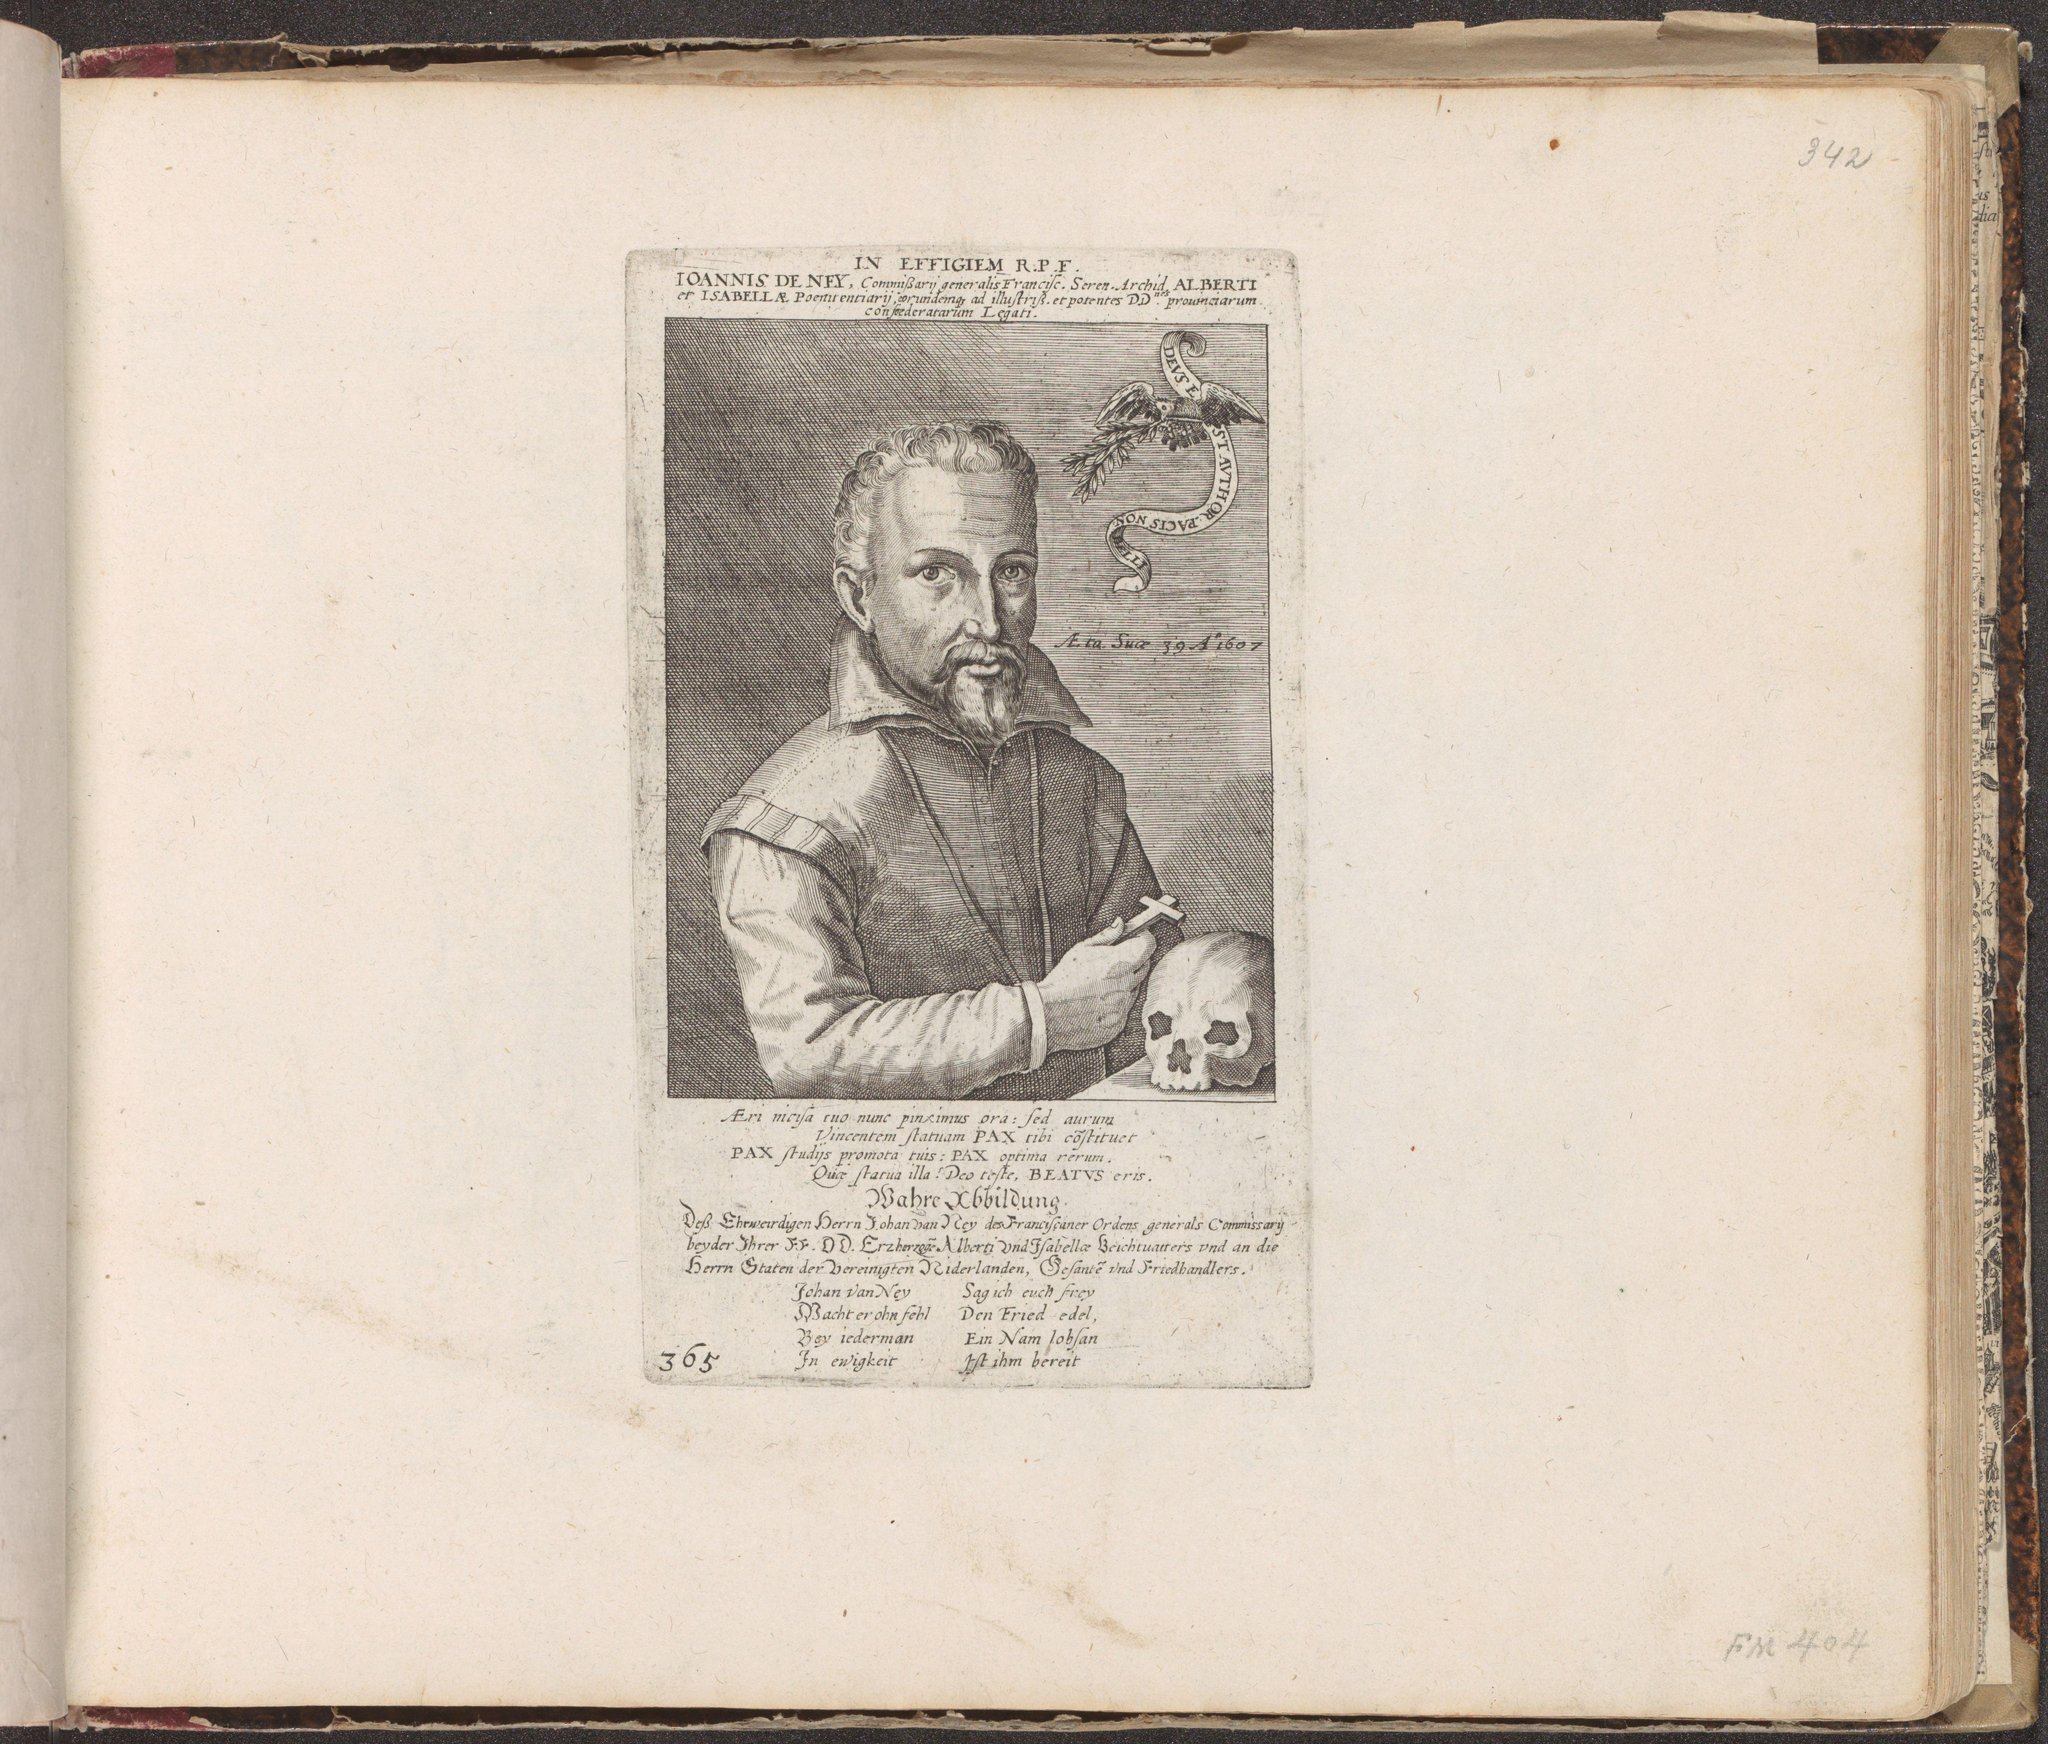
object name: album leaf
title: Serie 11: Varia Buitenlandse Gebeurtenissen, 1571-1631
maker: frans hogenberg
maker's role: print maker, publisher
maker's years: 1538-1590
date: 1607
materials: paper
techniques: engraving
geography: cologne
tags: antwerp, spain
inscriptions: date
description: Portret van Jan de Ney, in 1607 op 39-jarige leeftijd. Staande ten halven lijve met kruis en schedel. Afgezant van Albrecht en Isabella bij de vredesonderhandelingen voor het Twaalfjarig Bestand. Met onderschrift van 4 regels in het Latijn en 4 regels en een vers van 8 regels in het Duits. Linksonder genummerd: 365. De prent maakt deel uit van een album.